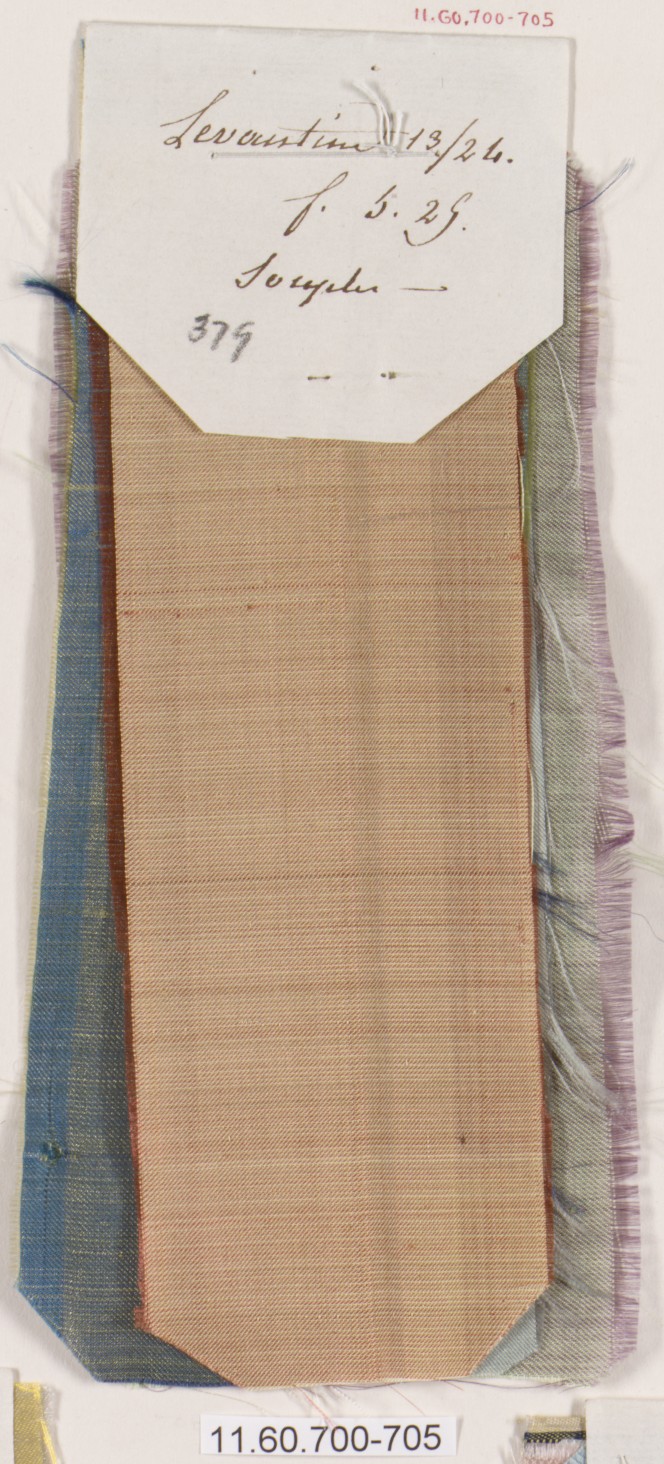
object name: sample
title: Samples (6)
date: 1801-1850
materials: silk